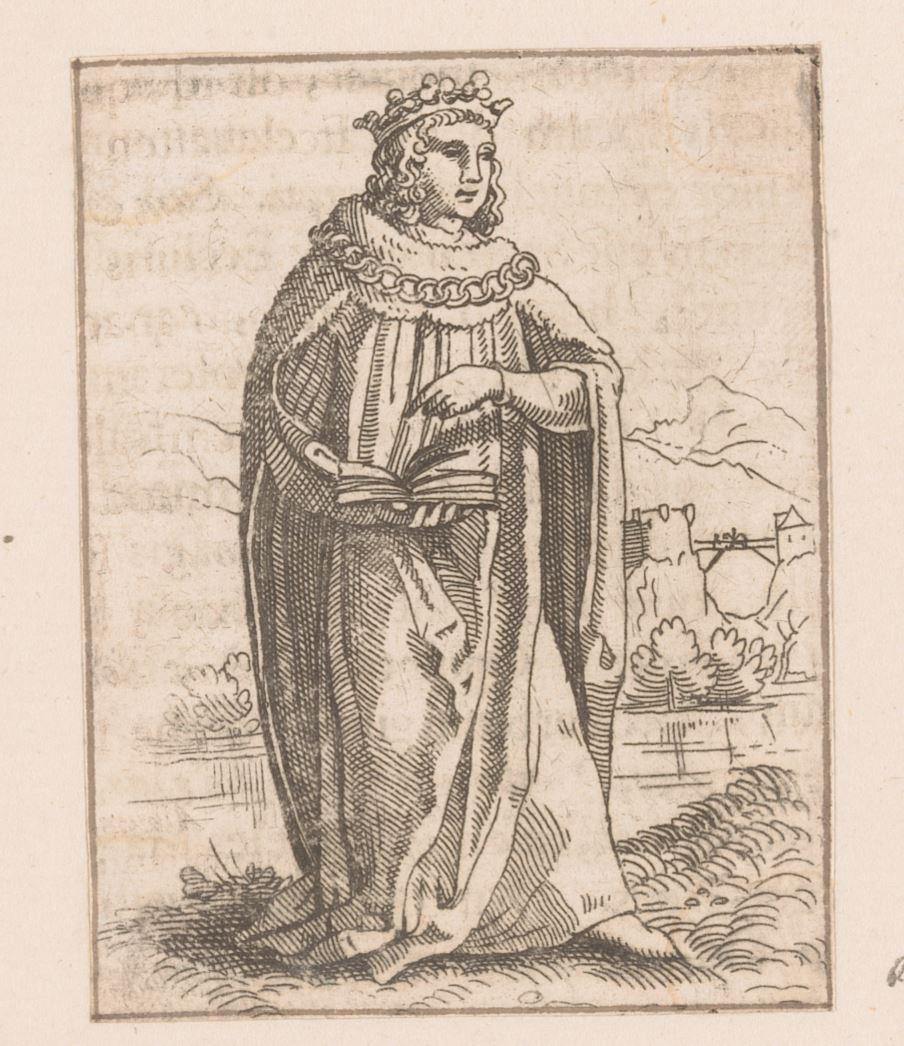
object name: book illustration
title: Illustraties uit de Lof der Zotheid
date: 1516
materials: paper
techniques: etching, letterpress printing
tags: desiderius erasmus, solomon (not in biblical context); possible attributes of solomon: crown, sceptre, sword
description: Prent afkomstig uit: Erasmus, Desiderius. Morias enkomion (...). Bazel: Johann Rudolf Genath, 1676. De prenten hierin zijn naar tekeningen die Hans en Ambrosius Holbein maakten voor de theoloog Oswald Myconius in diens uitgave van de Moriae encomium (Lof der Zotheid) van 1516.